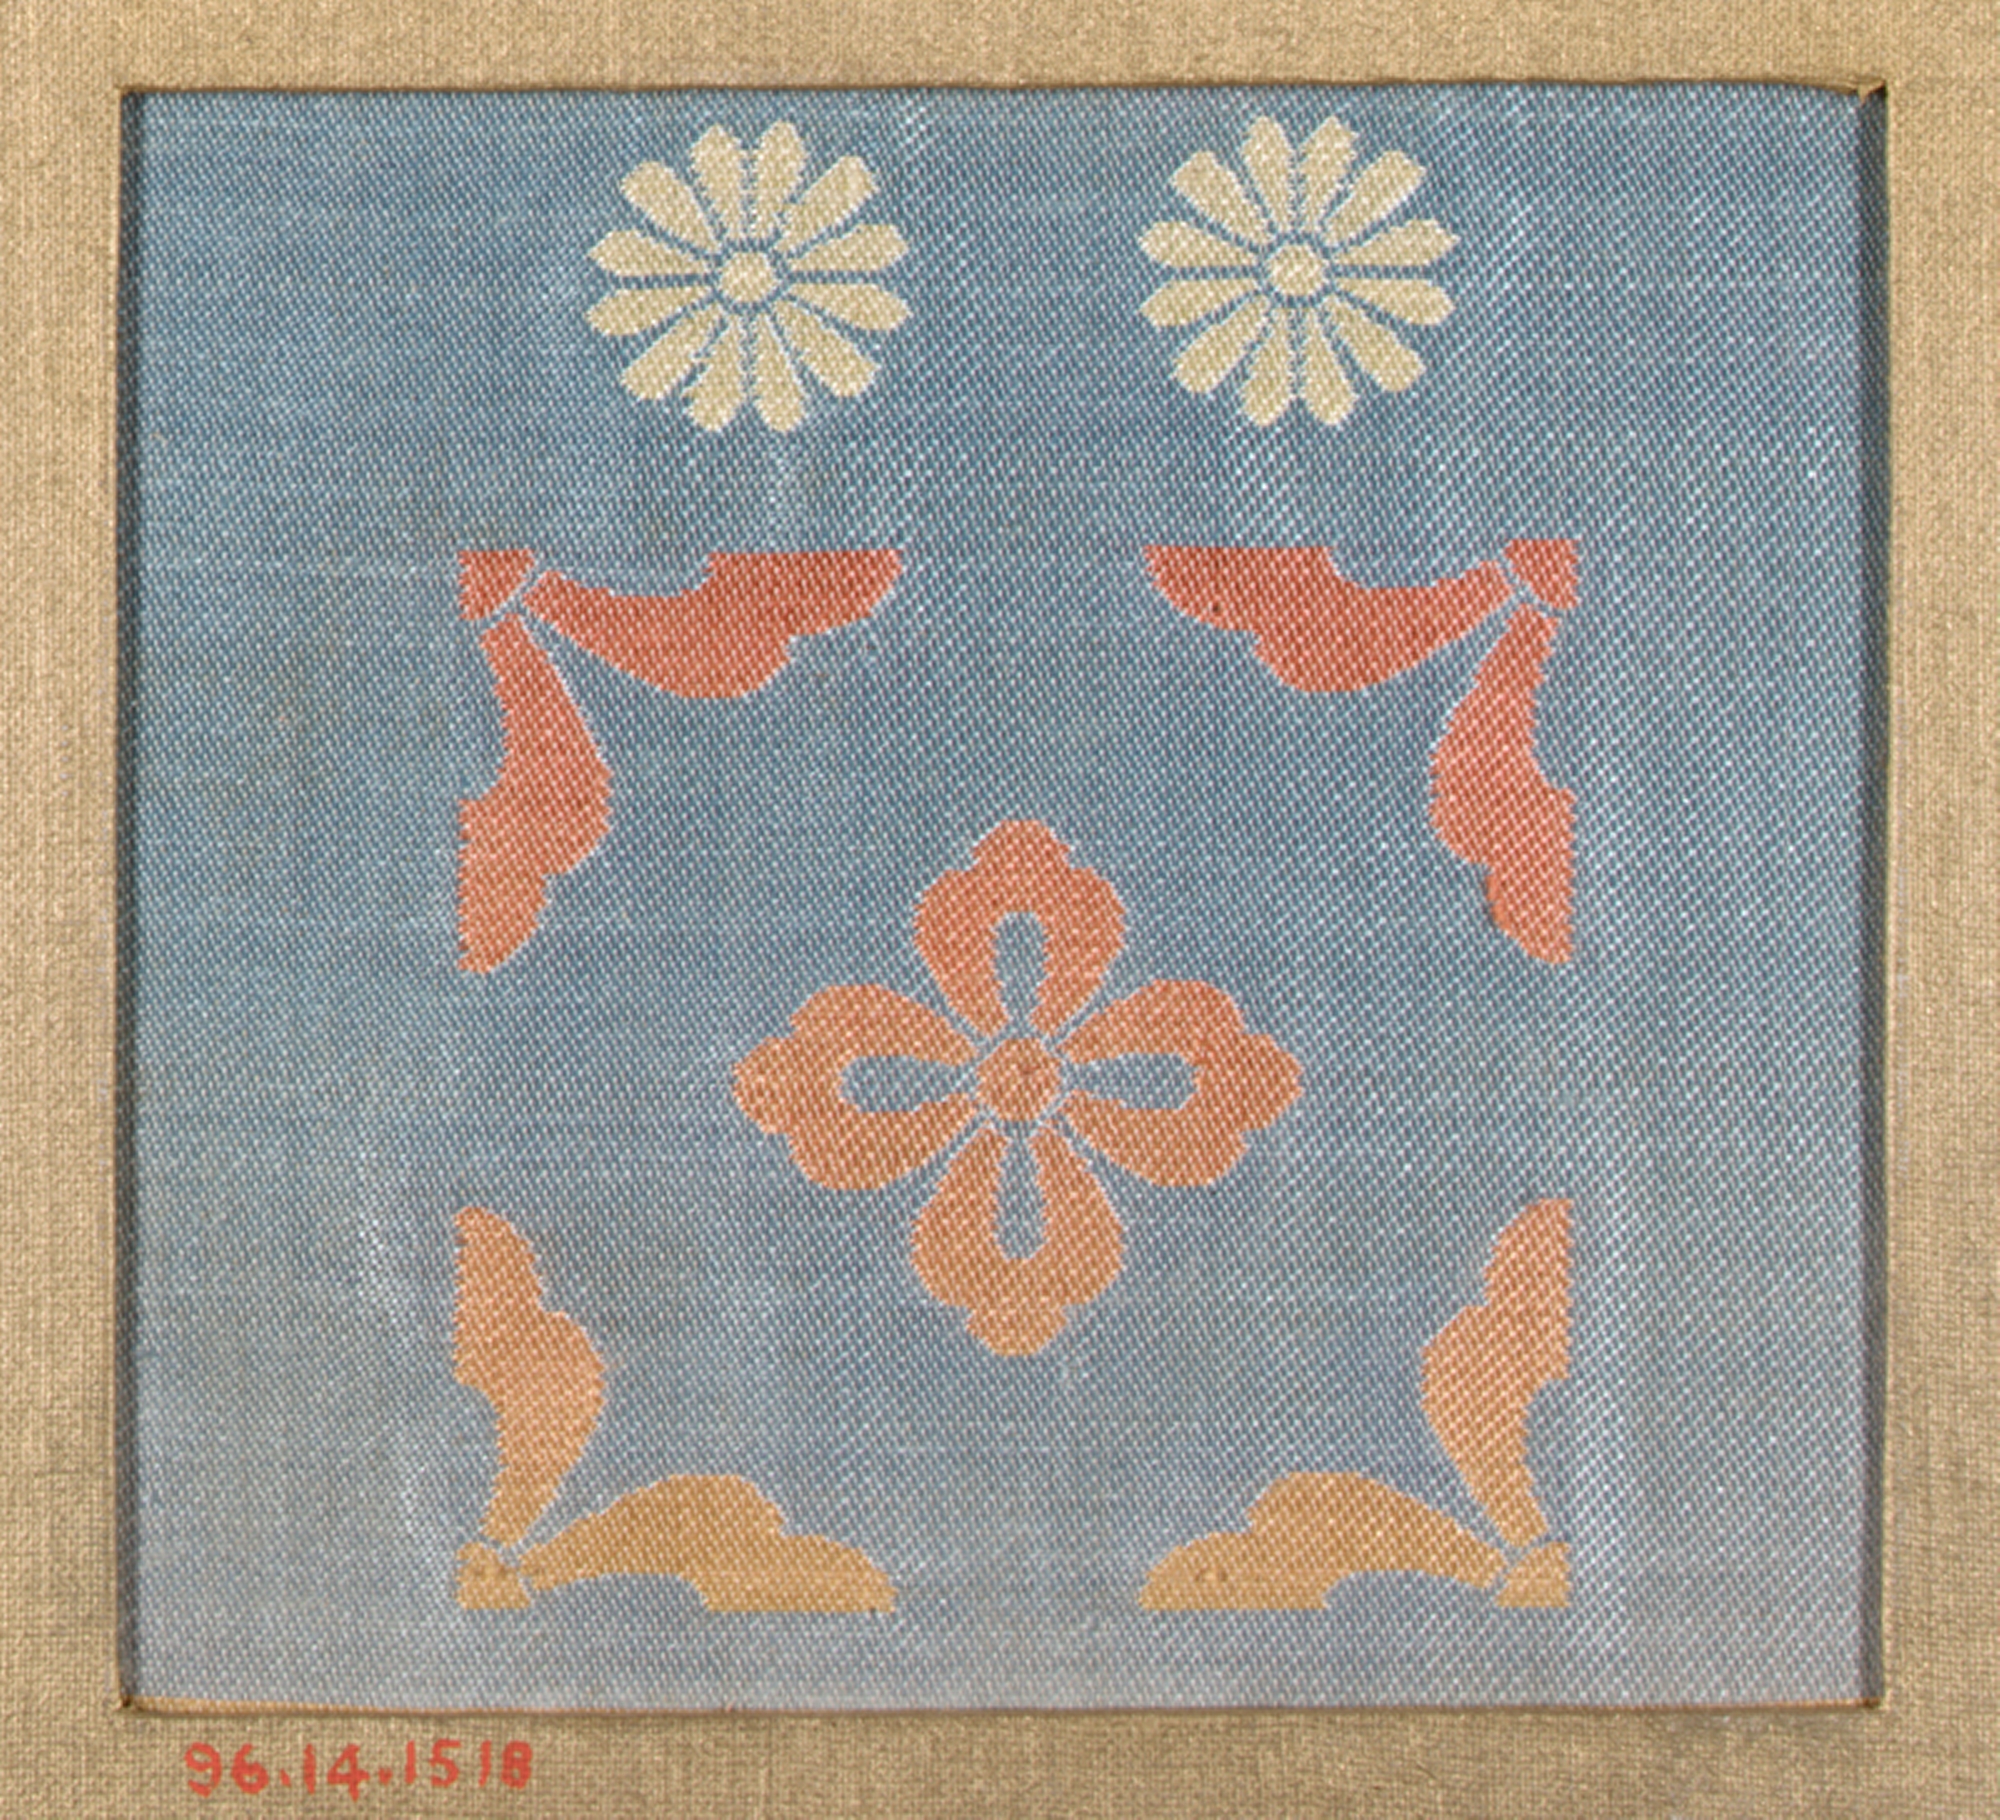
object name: piece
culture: japanese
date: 1701-1900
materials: silk